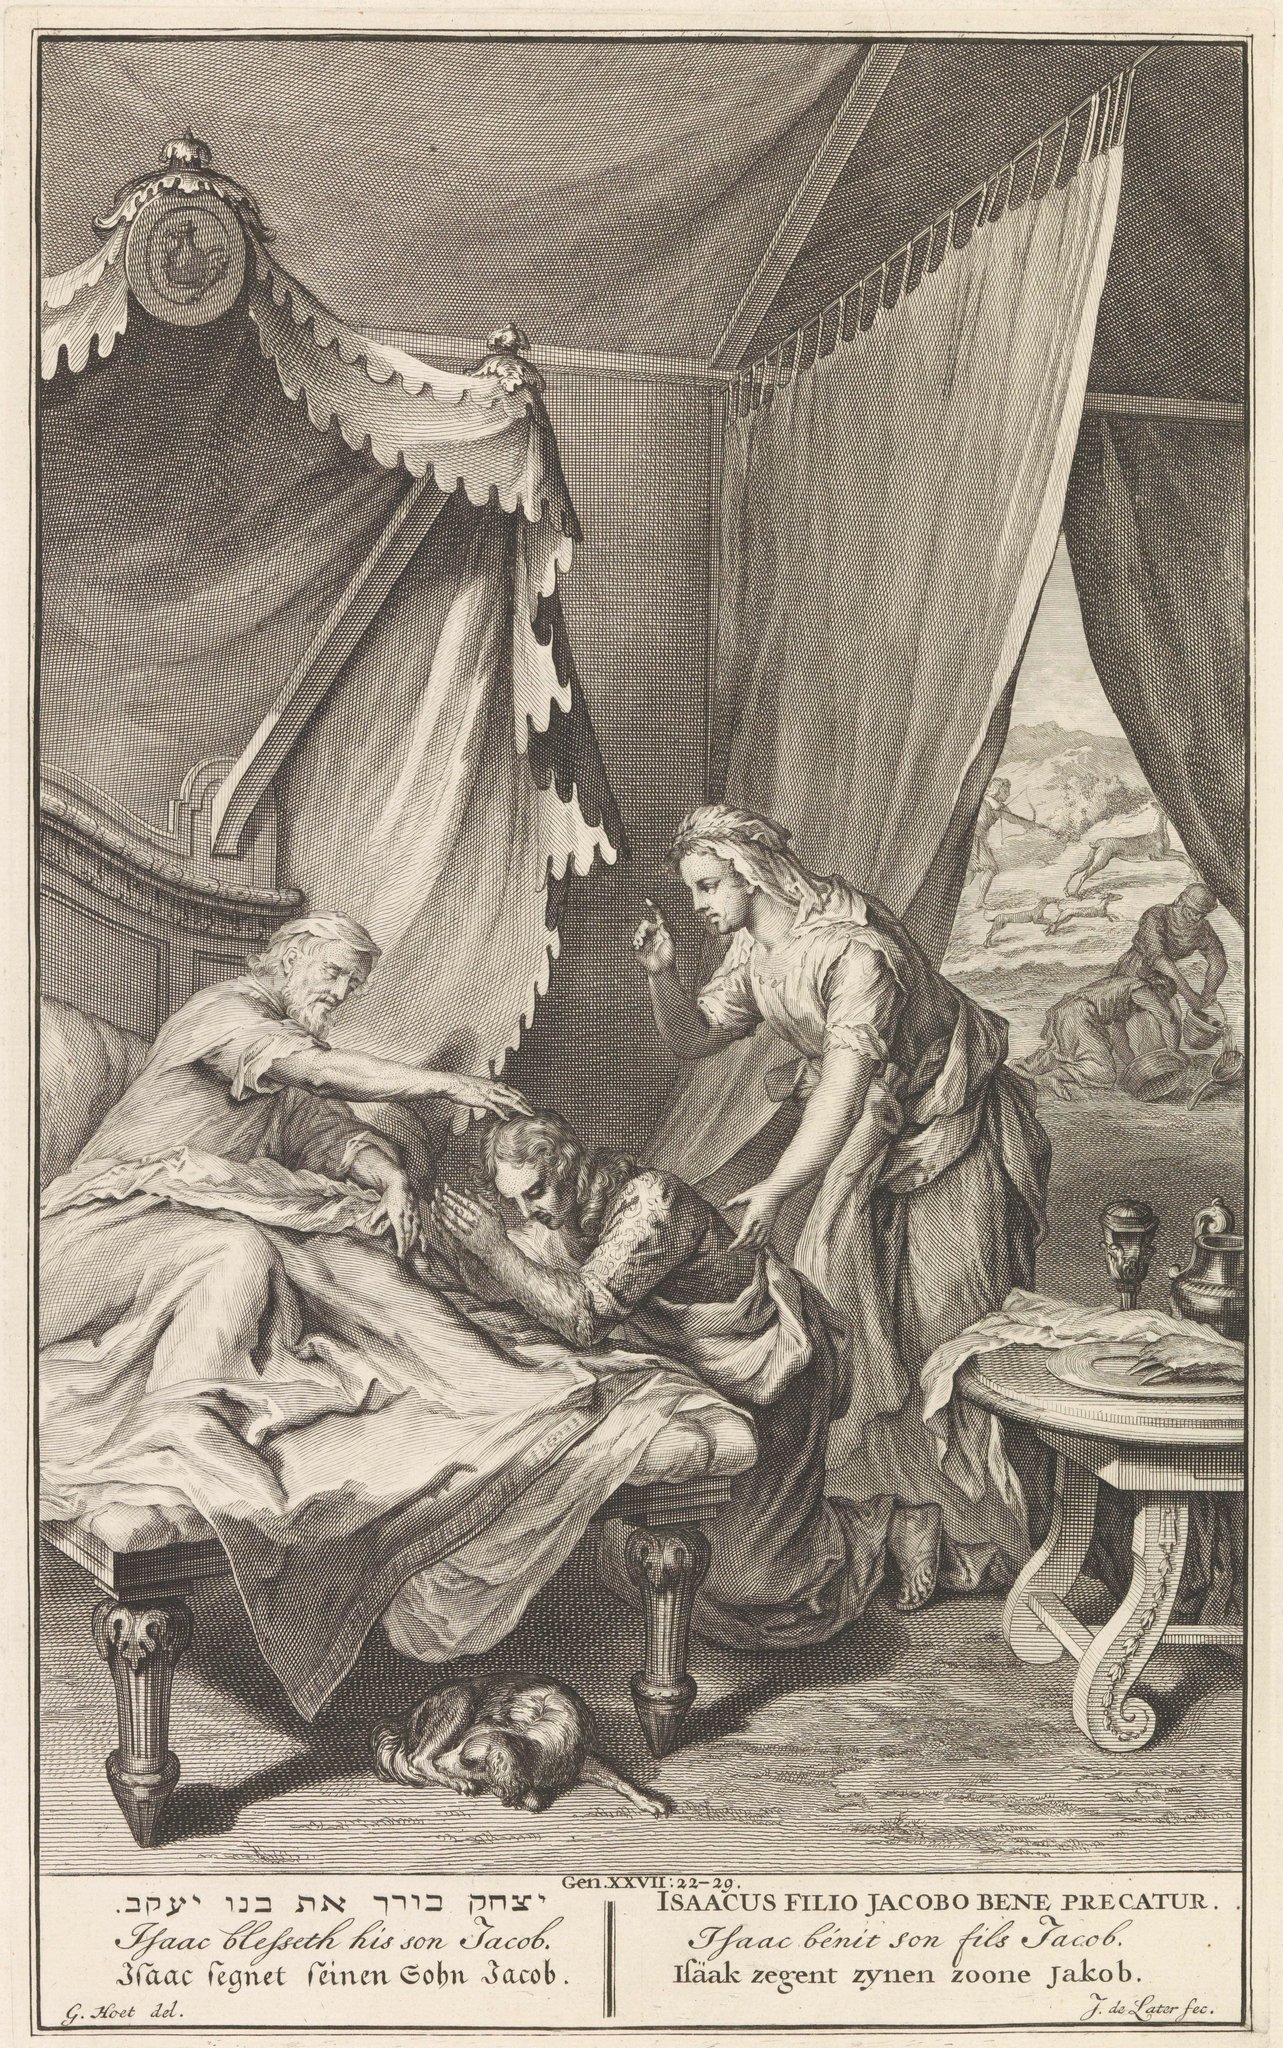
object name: print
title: Isaak zegent Jakob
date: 1728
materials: paper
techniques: engraving, etching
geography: amsterdam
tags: isaac lying in bed blesses jacob who, disguised in esau's clothes, brings food to his father; jacob's hands and neck are covered with goatskins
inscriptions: number: ‘26’, collector's mark: Lugt 2228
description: De oude Isaak zit in bed en geeft zijn vaderlijke zegen aan de geknielde Jakob, die zich voordoet als Esau. Achter Isaak staat Rebekka met geheven vinger. Rechts op de achtergrond zicht op het veld waar Esau met pijl en boog een hert schiet. Bijbelse voorstelling uit Gen. 27: 22-29 met in de marge de titel van de voorstelling in zes talen.